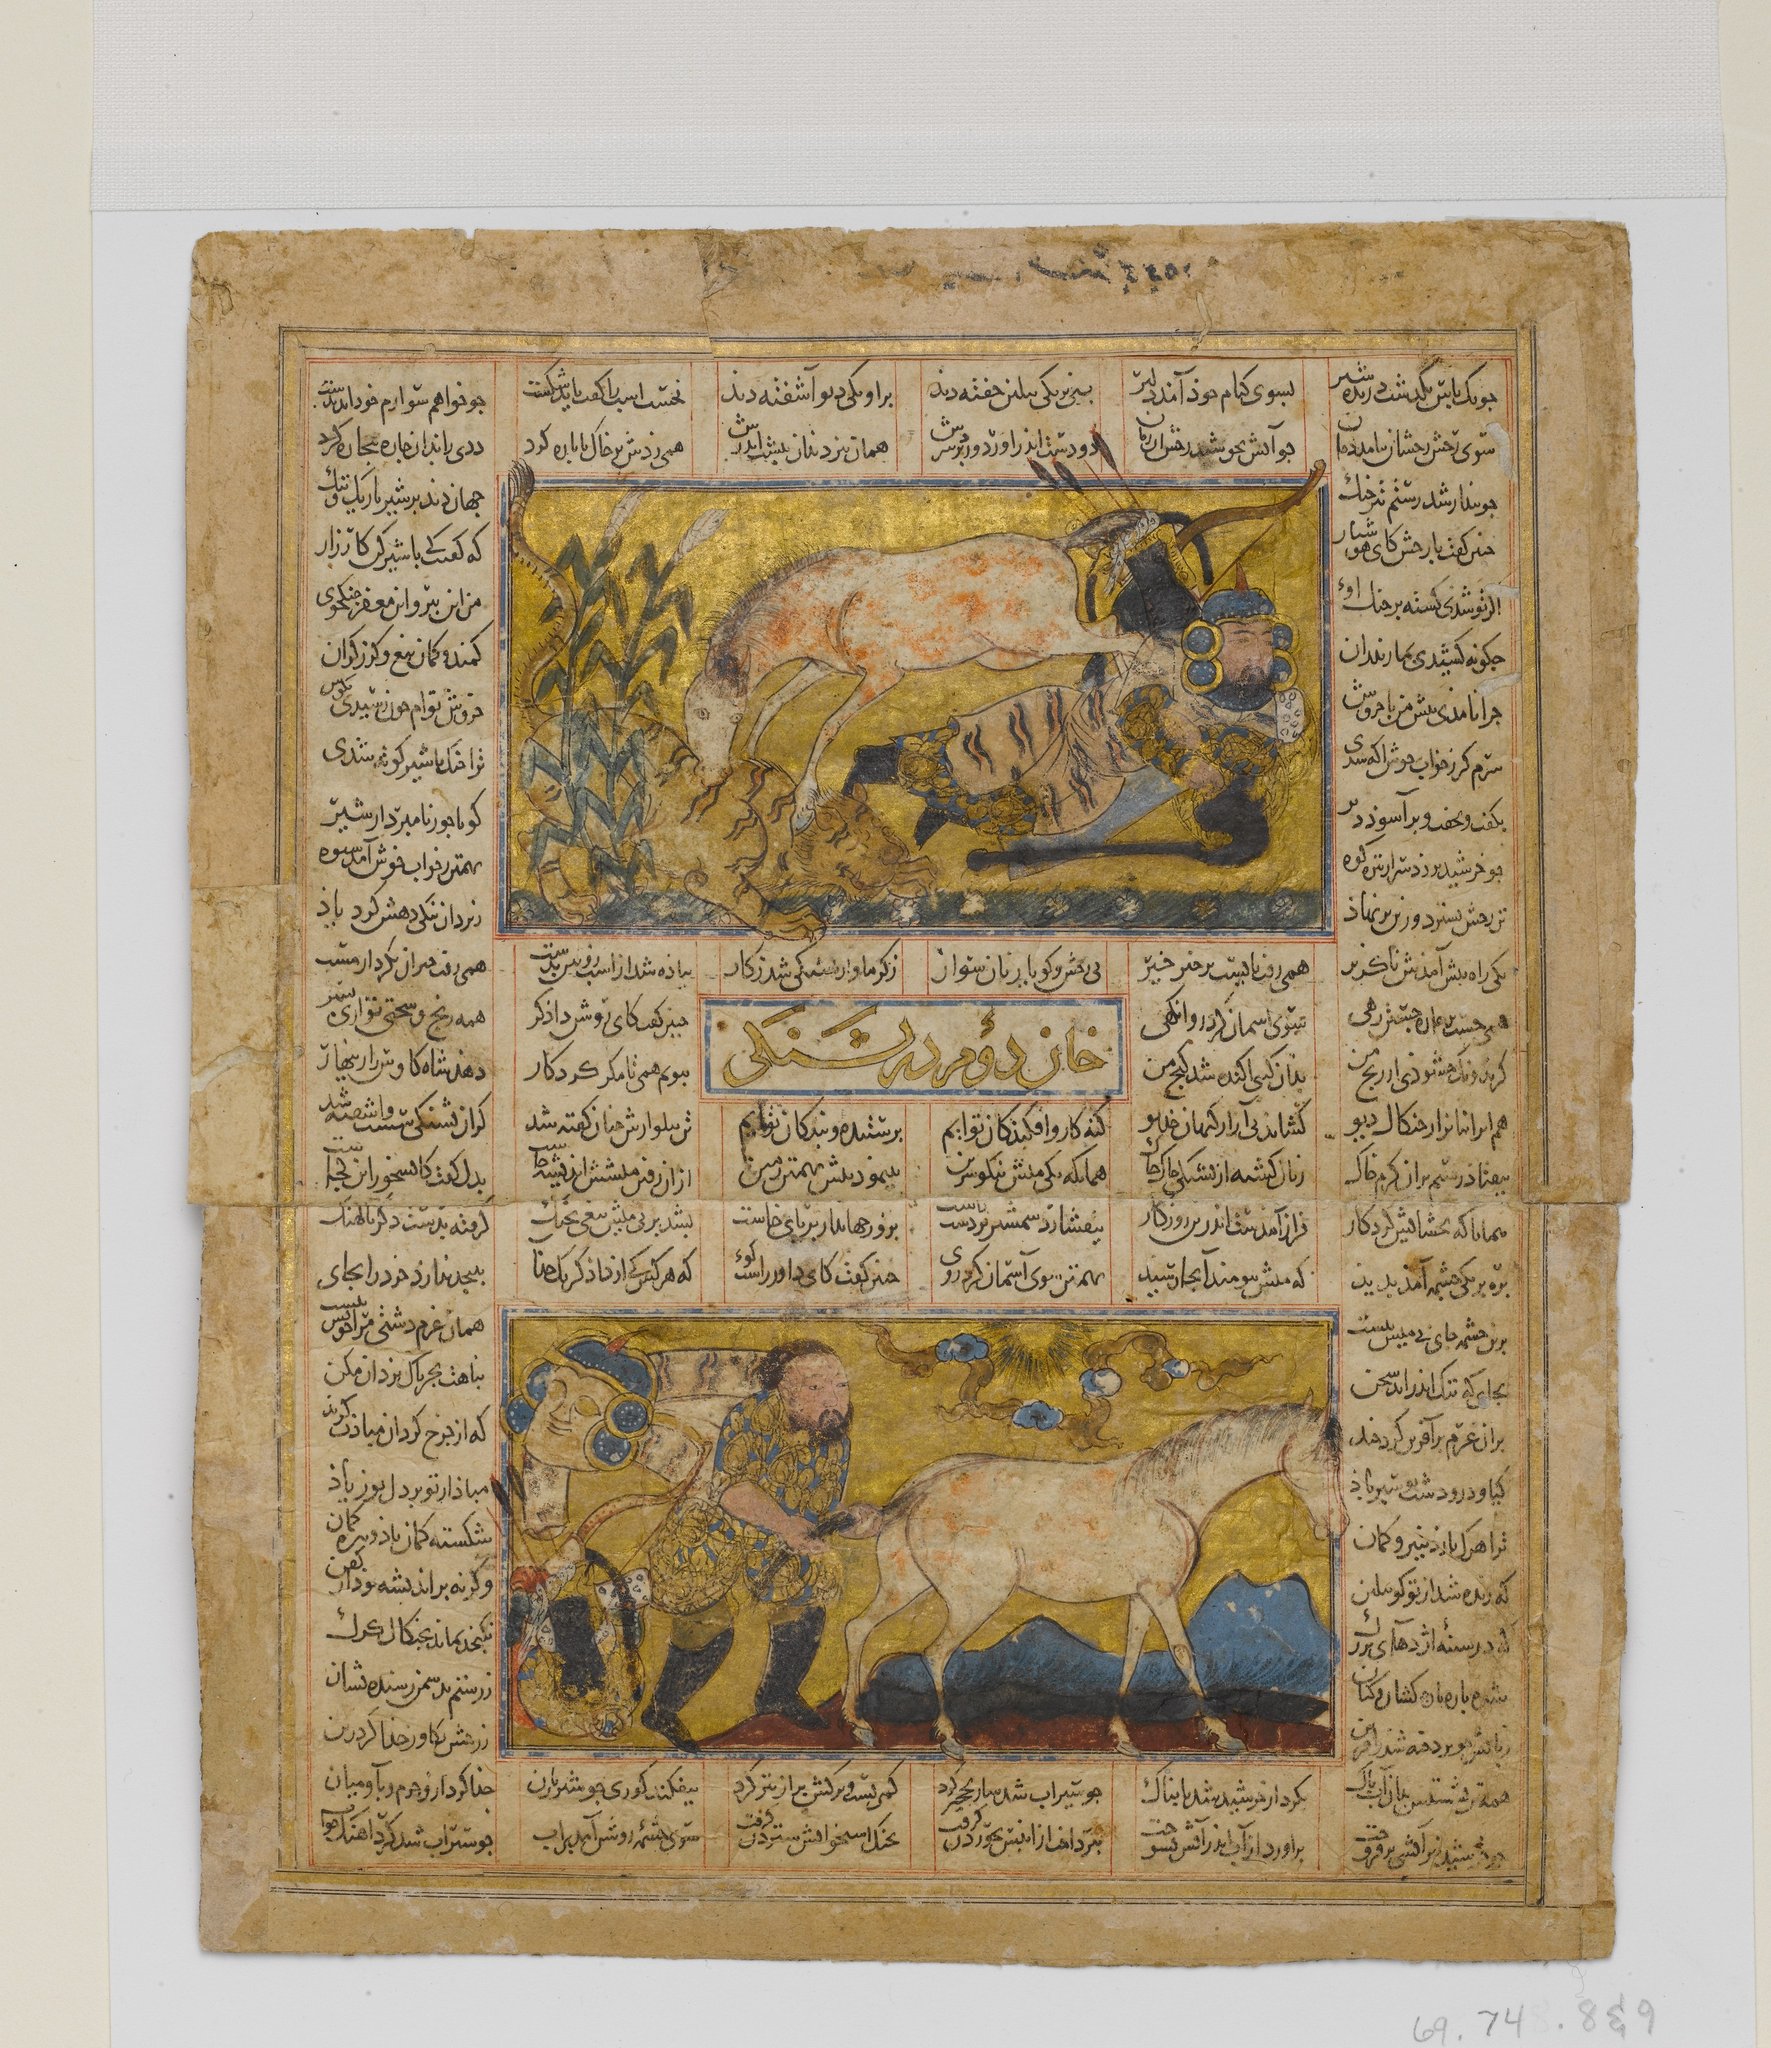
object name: folio from an illustrated manuscript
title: "How Rustam Found a Spring", Folio from a Shahnama (Book of Kings) of Firdausi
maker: abu'l qasim firdausi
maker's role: author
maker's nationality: iranian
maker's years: 935-1020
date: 1300-1330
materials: gold, ink, paper, silver, watercolor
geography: iran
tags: animals,men,poets